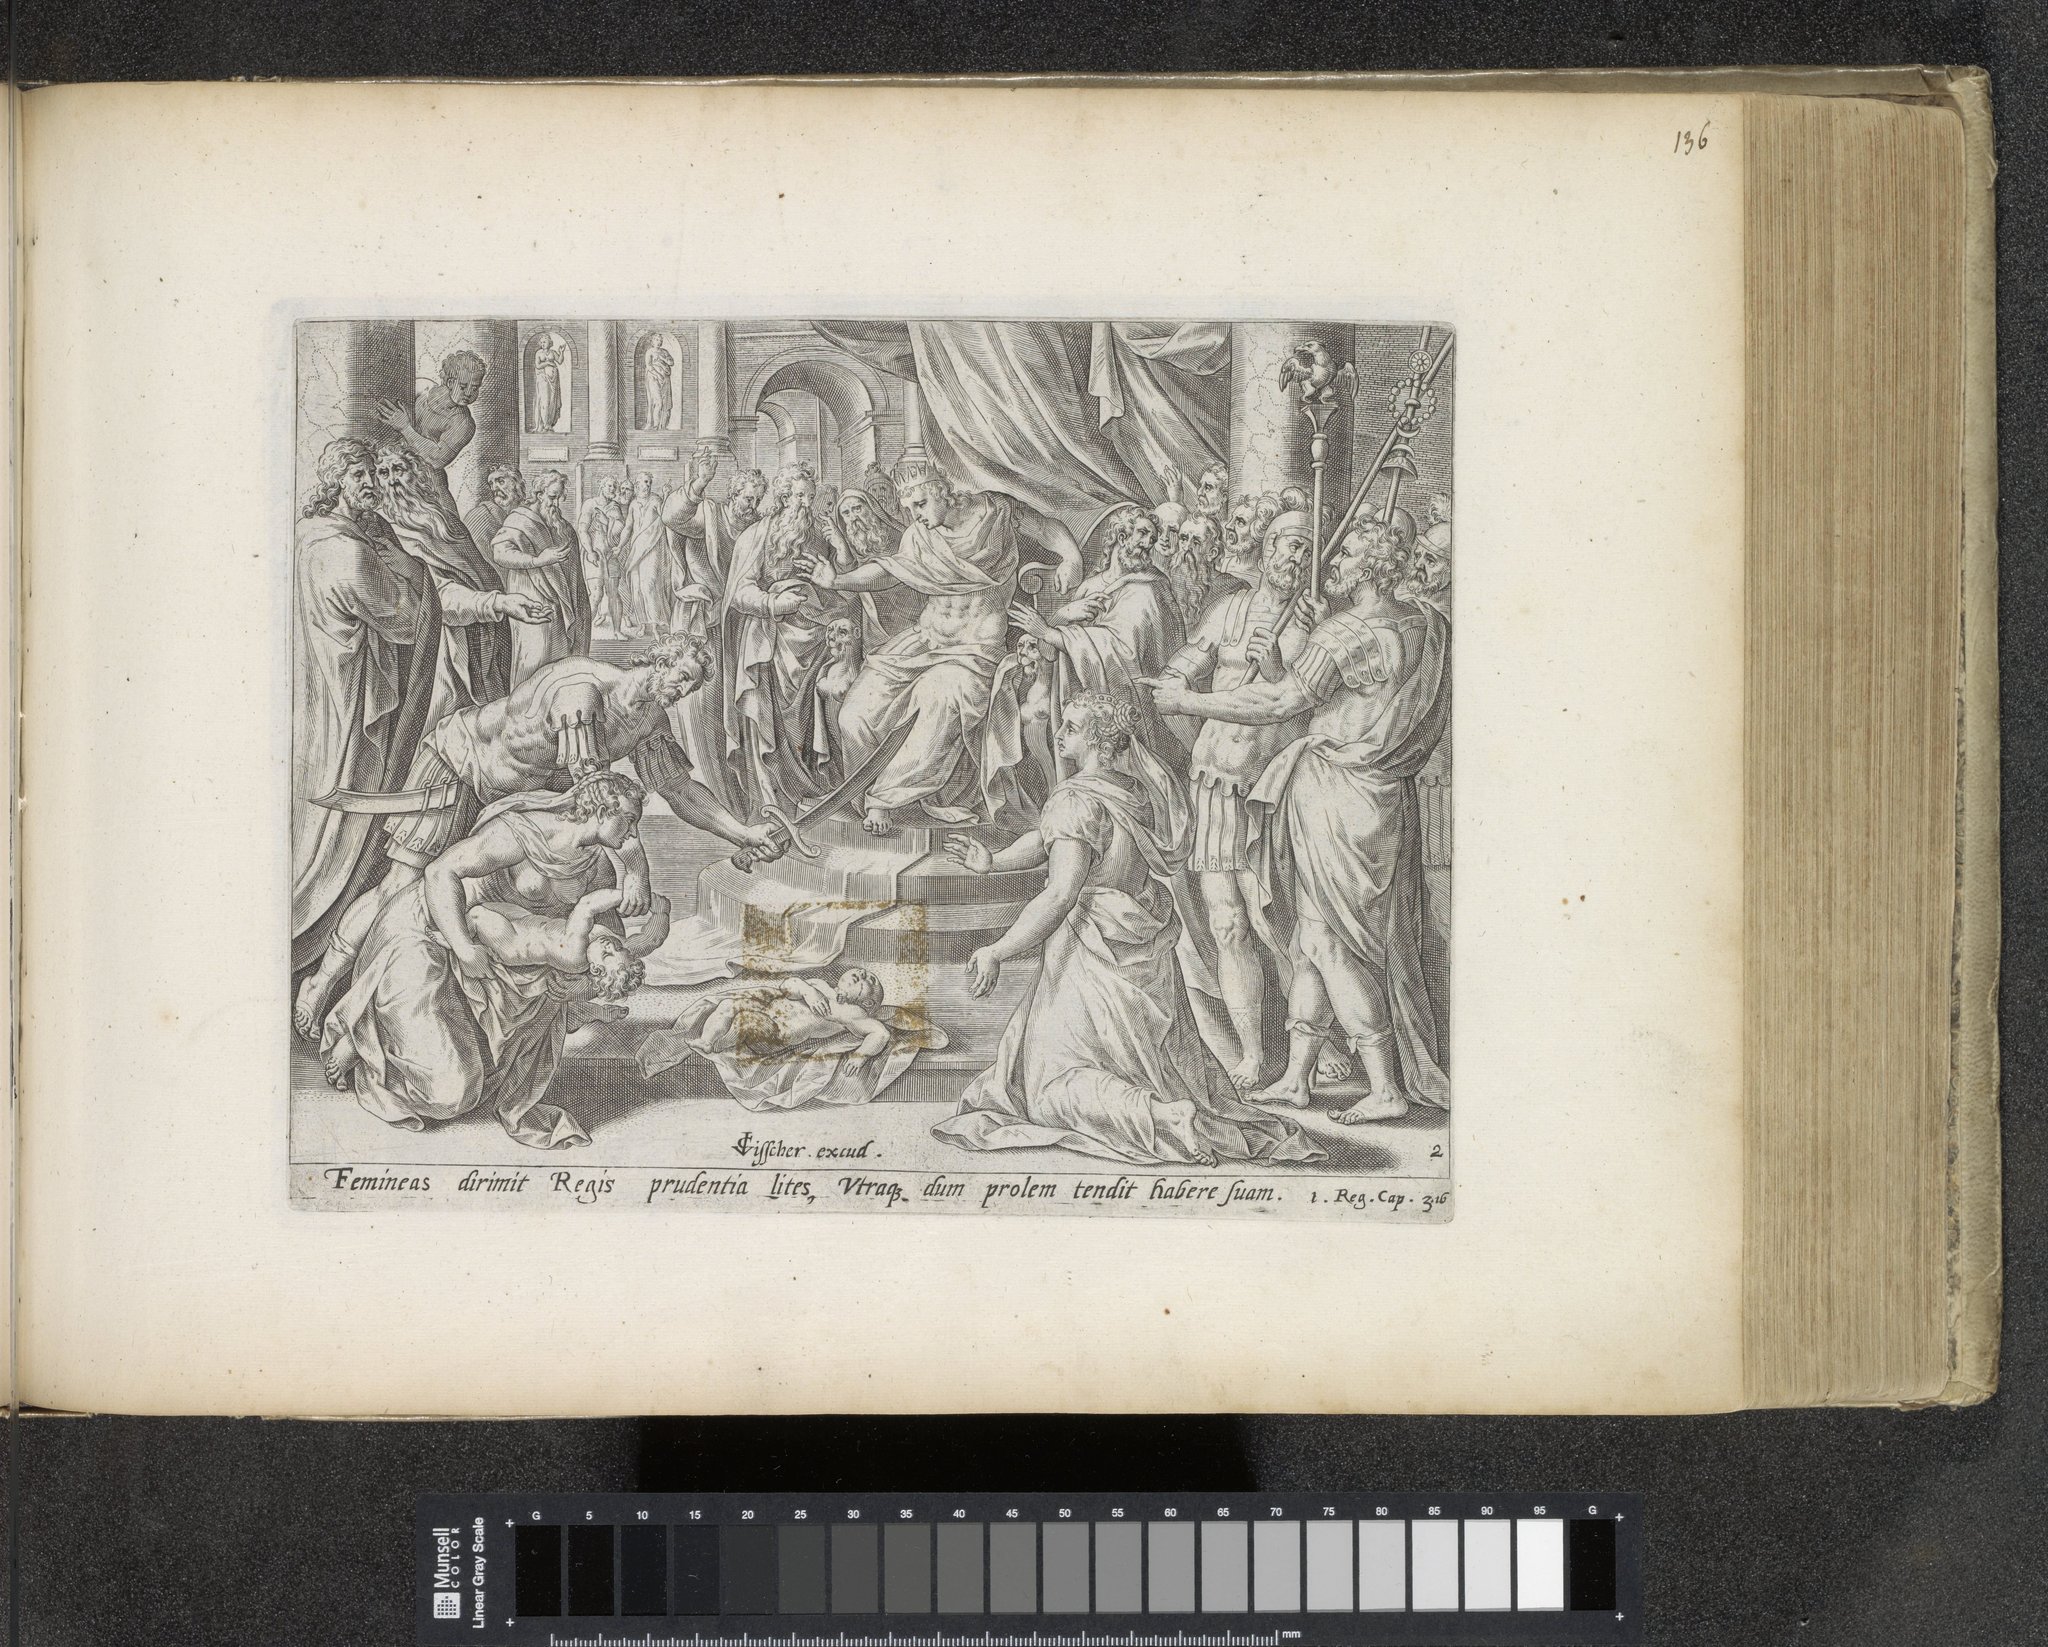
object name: print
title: Oordeel van Salomo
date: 1579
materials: paper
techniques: engraving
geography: amsterdam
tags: solomon gives verdict; he commands a soldier to divide the living child in two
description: Koning Salomo zit op zijn troon en velt zijn oordeel. Voor de troon de twee vrouwen die beiden het moederschap van het levende kind claimen. Op de grond ligt het overleden kind. Salomo geeft de opdracht om de levende baby in tweeën te laten delen om te bepalen wie de moeder van het kind is. Een man trekt zijn zwaard en pakt het kind bij de arm. Onder de voorstelling een verwijzing in het Latijn naar de Bijbeltekst in 1 Kon. 3:16. Deze prent maakt deel uit van een album.